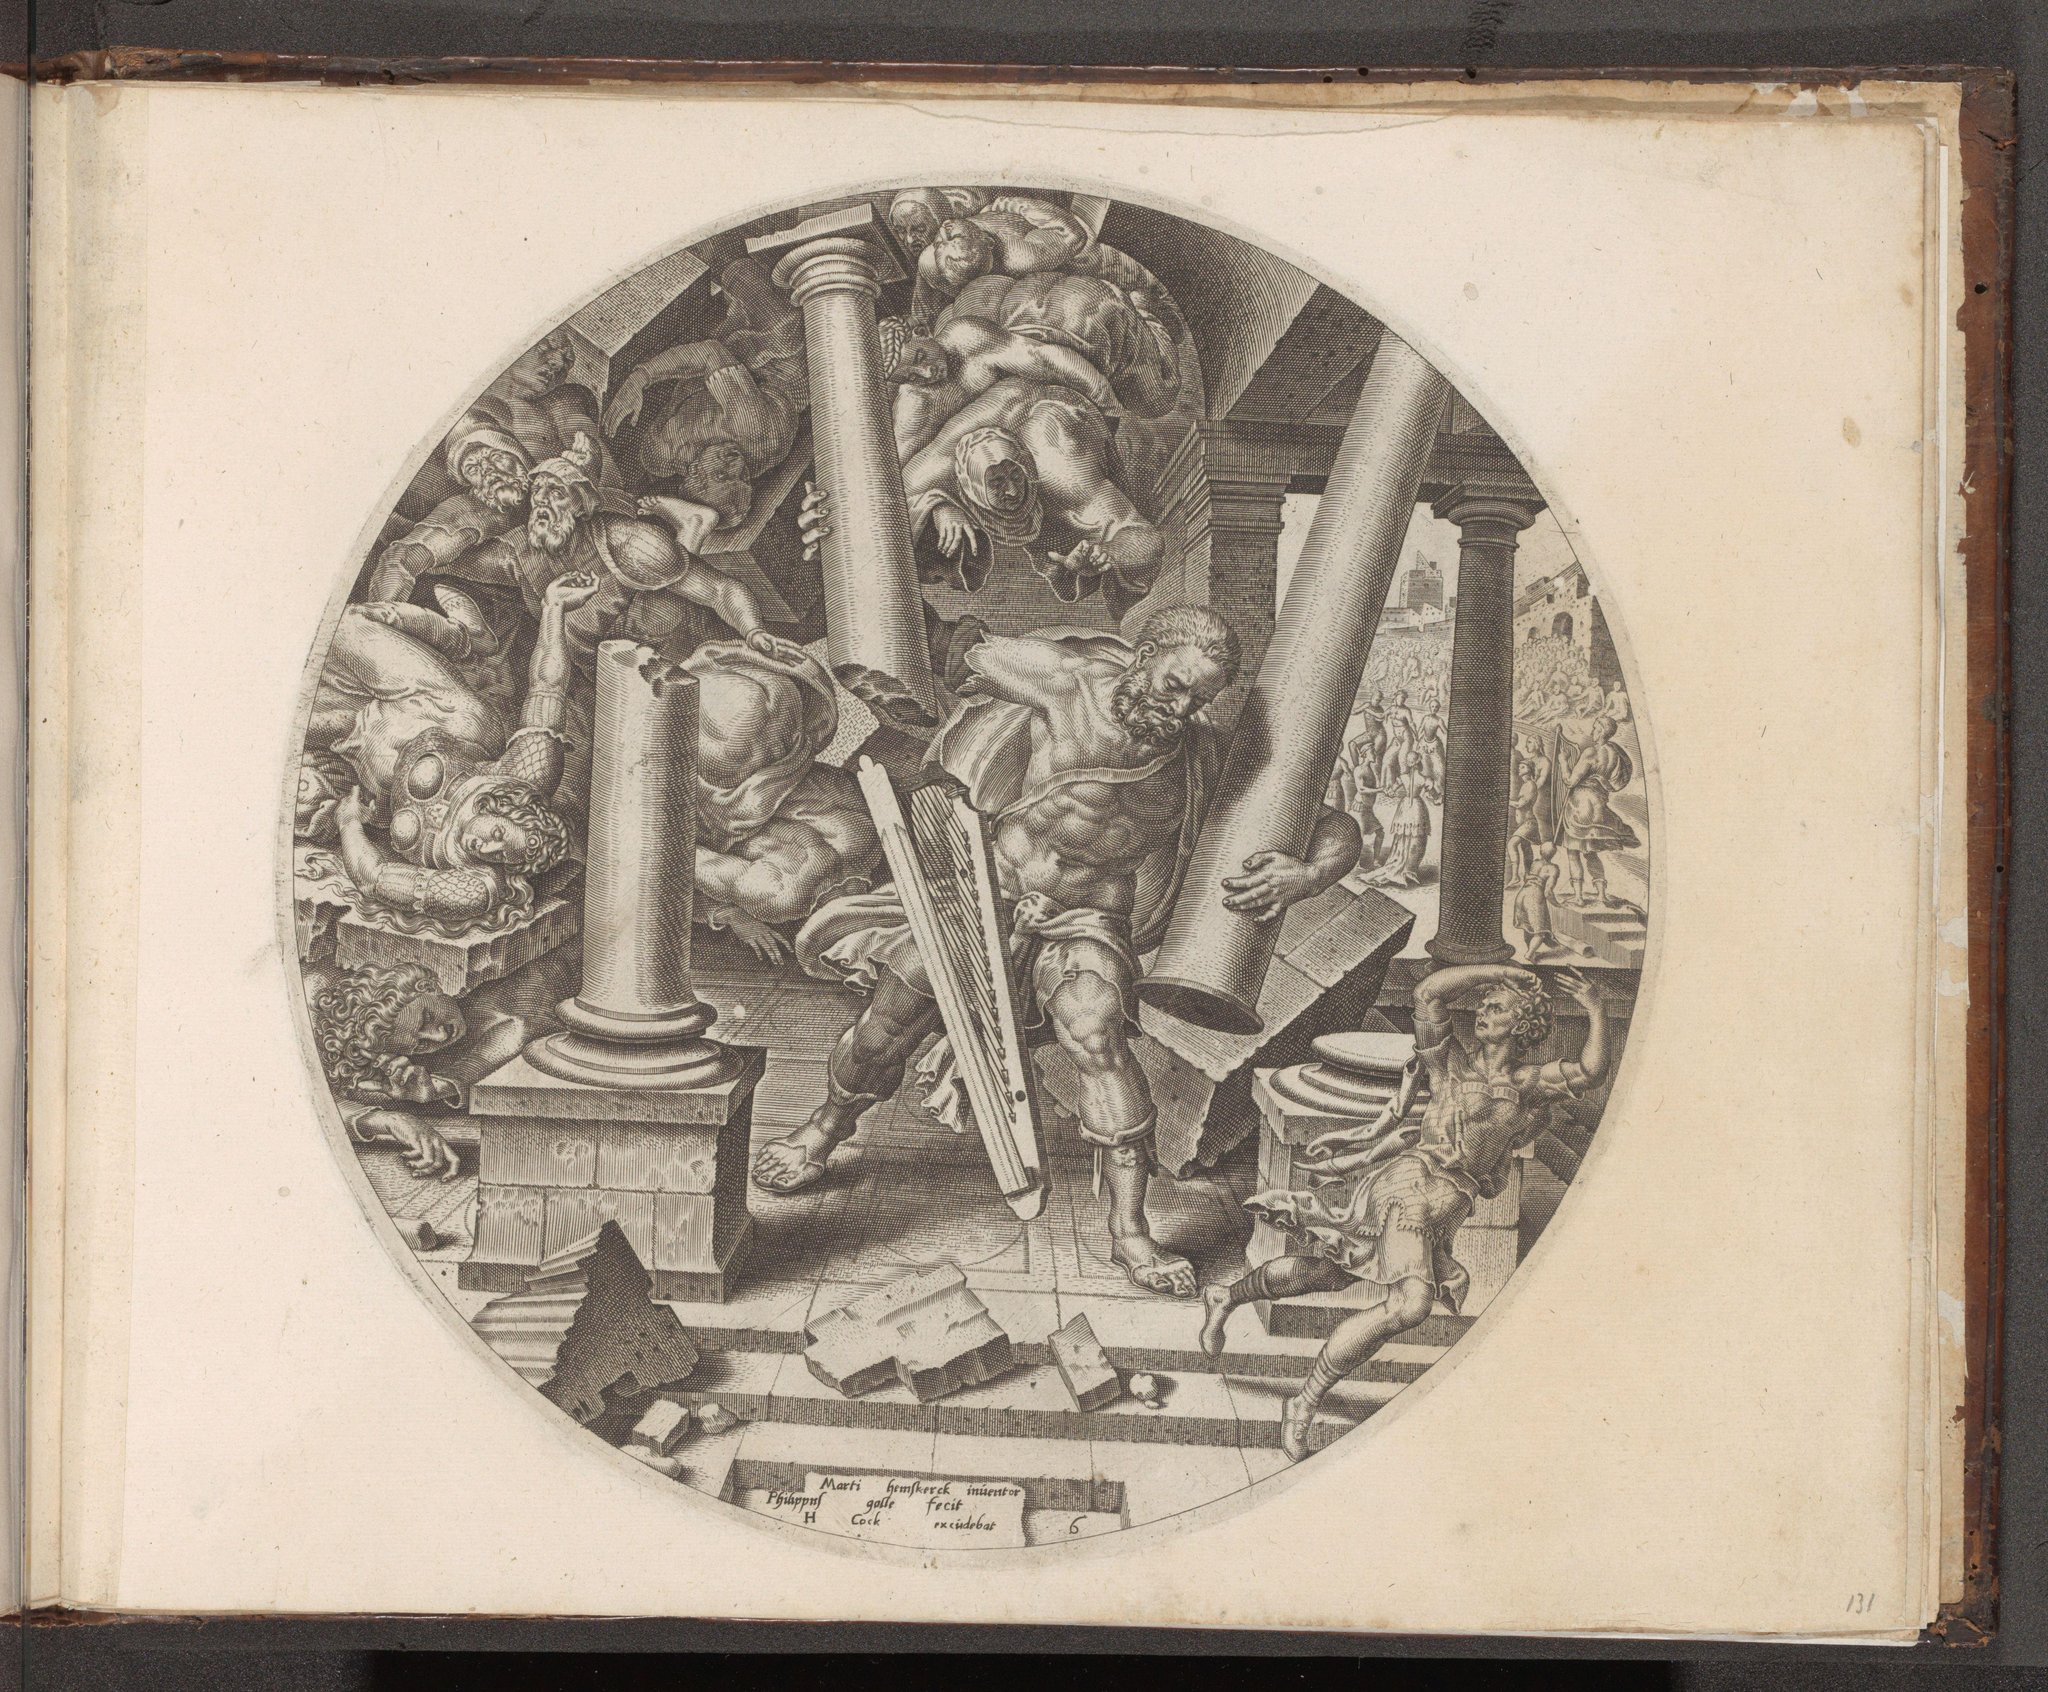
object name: album leaf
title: Simson verwoest de tempel van de Filistijnen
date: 1558-1562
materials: paper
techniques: engraving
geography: antwerp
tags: samson breaks the pillars; the temple of dagon collapses, killing all that are in it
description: Simson vernielt met zijn laatste krachten de zuilen van de tempel en doodt zo zichzelf en de aanwezige Filistijnen. Een harpspeler probeert te vluchten, zijn harp vliegt door de lucht. Mensen die op het dak stonden vallen naar beneden. Prent maakt deel uit van een album.